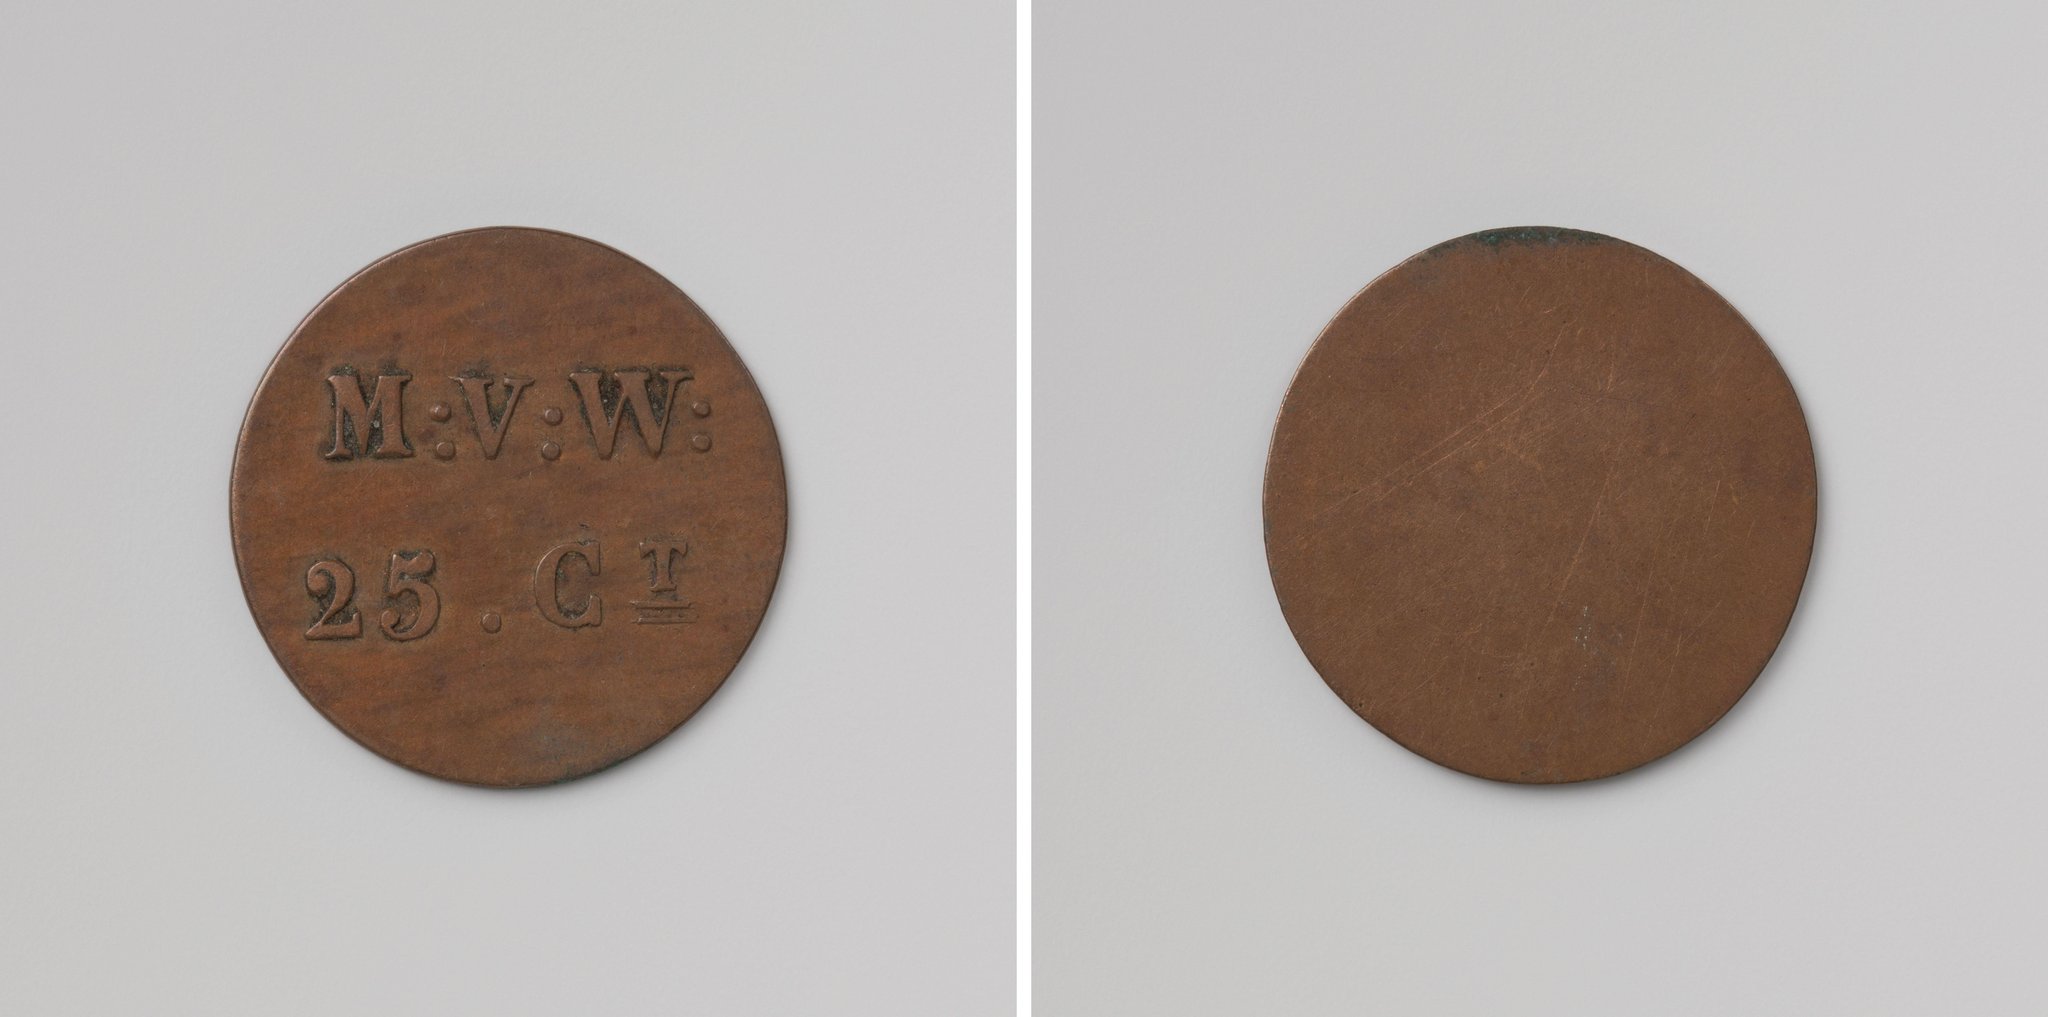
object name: monetary token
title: Huismunt geslagen op last van de Maatschappij van Weldadigheid ter waarde van 25 cent, ten behoeve van de Gewone Koloniën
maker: Anonymous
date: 1818-1859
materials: copper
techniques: striking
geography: netherlands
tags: maatschappij van weldadigheid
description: eenzijdige munt. Voorzijde: opschrift boven waardeaanduiding. Keerzijde: blanco